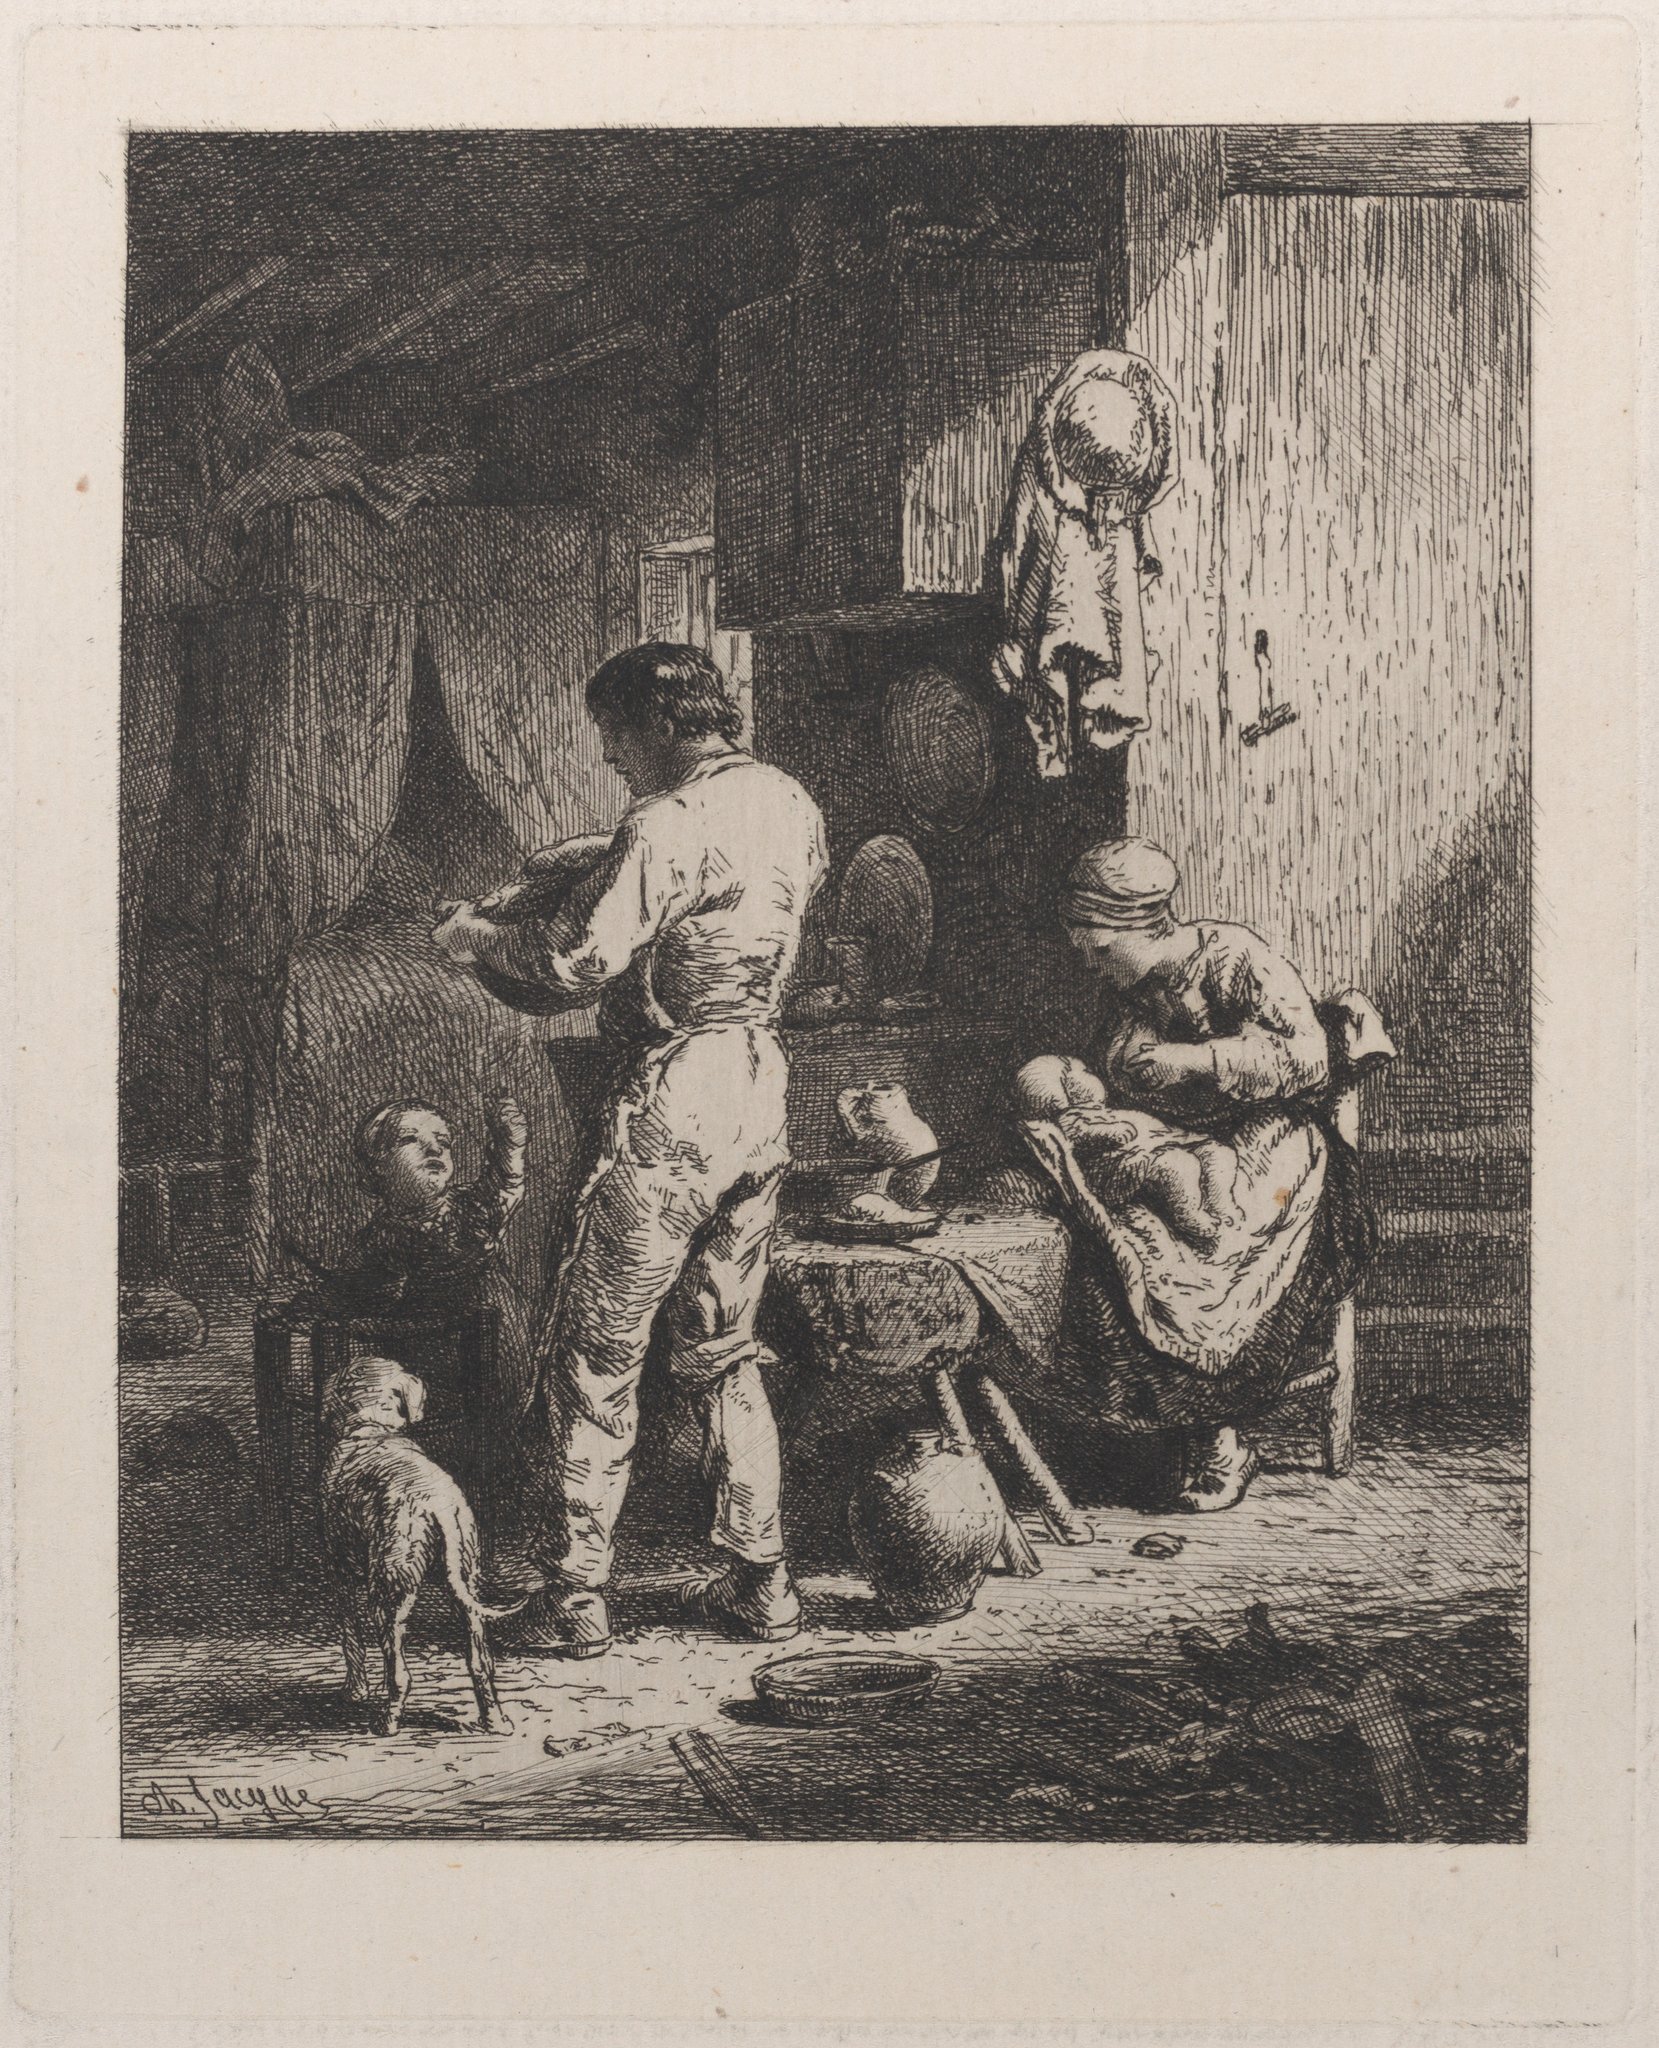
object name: print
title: The Meal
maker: charles émile jacque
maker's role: artist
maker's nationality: french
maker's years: 1813-1894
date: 1864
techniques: etching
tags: interiors,children,men,women,dogs,eating,nursing